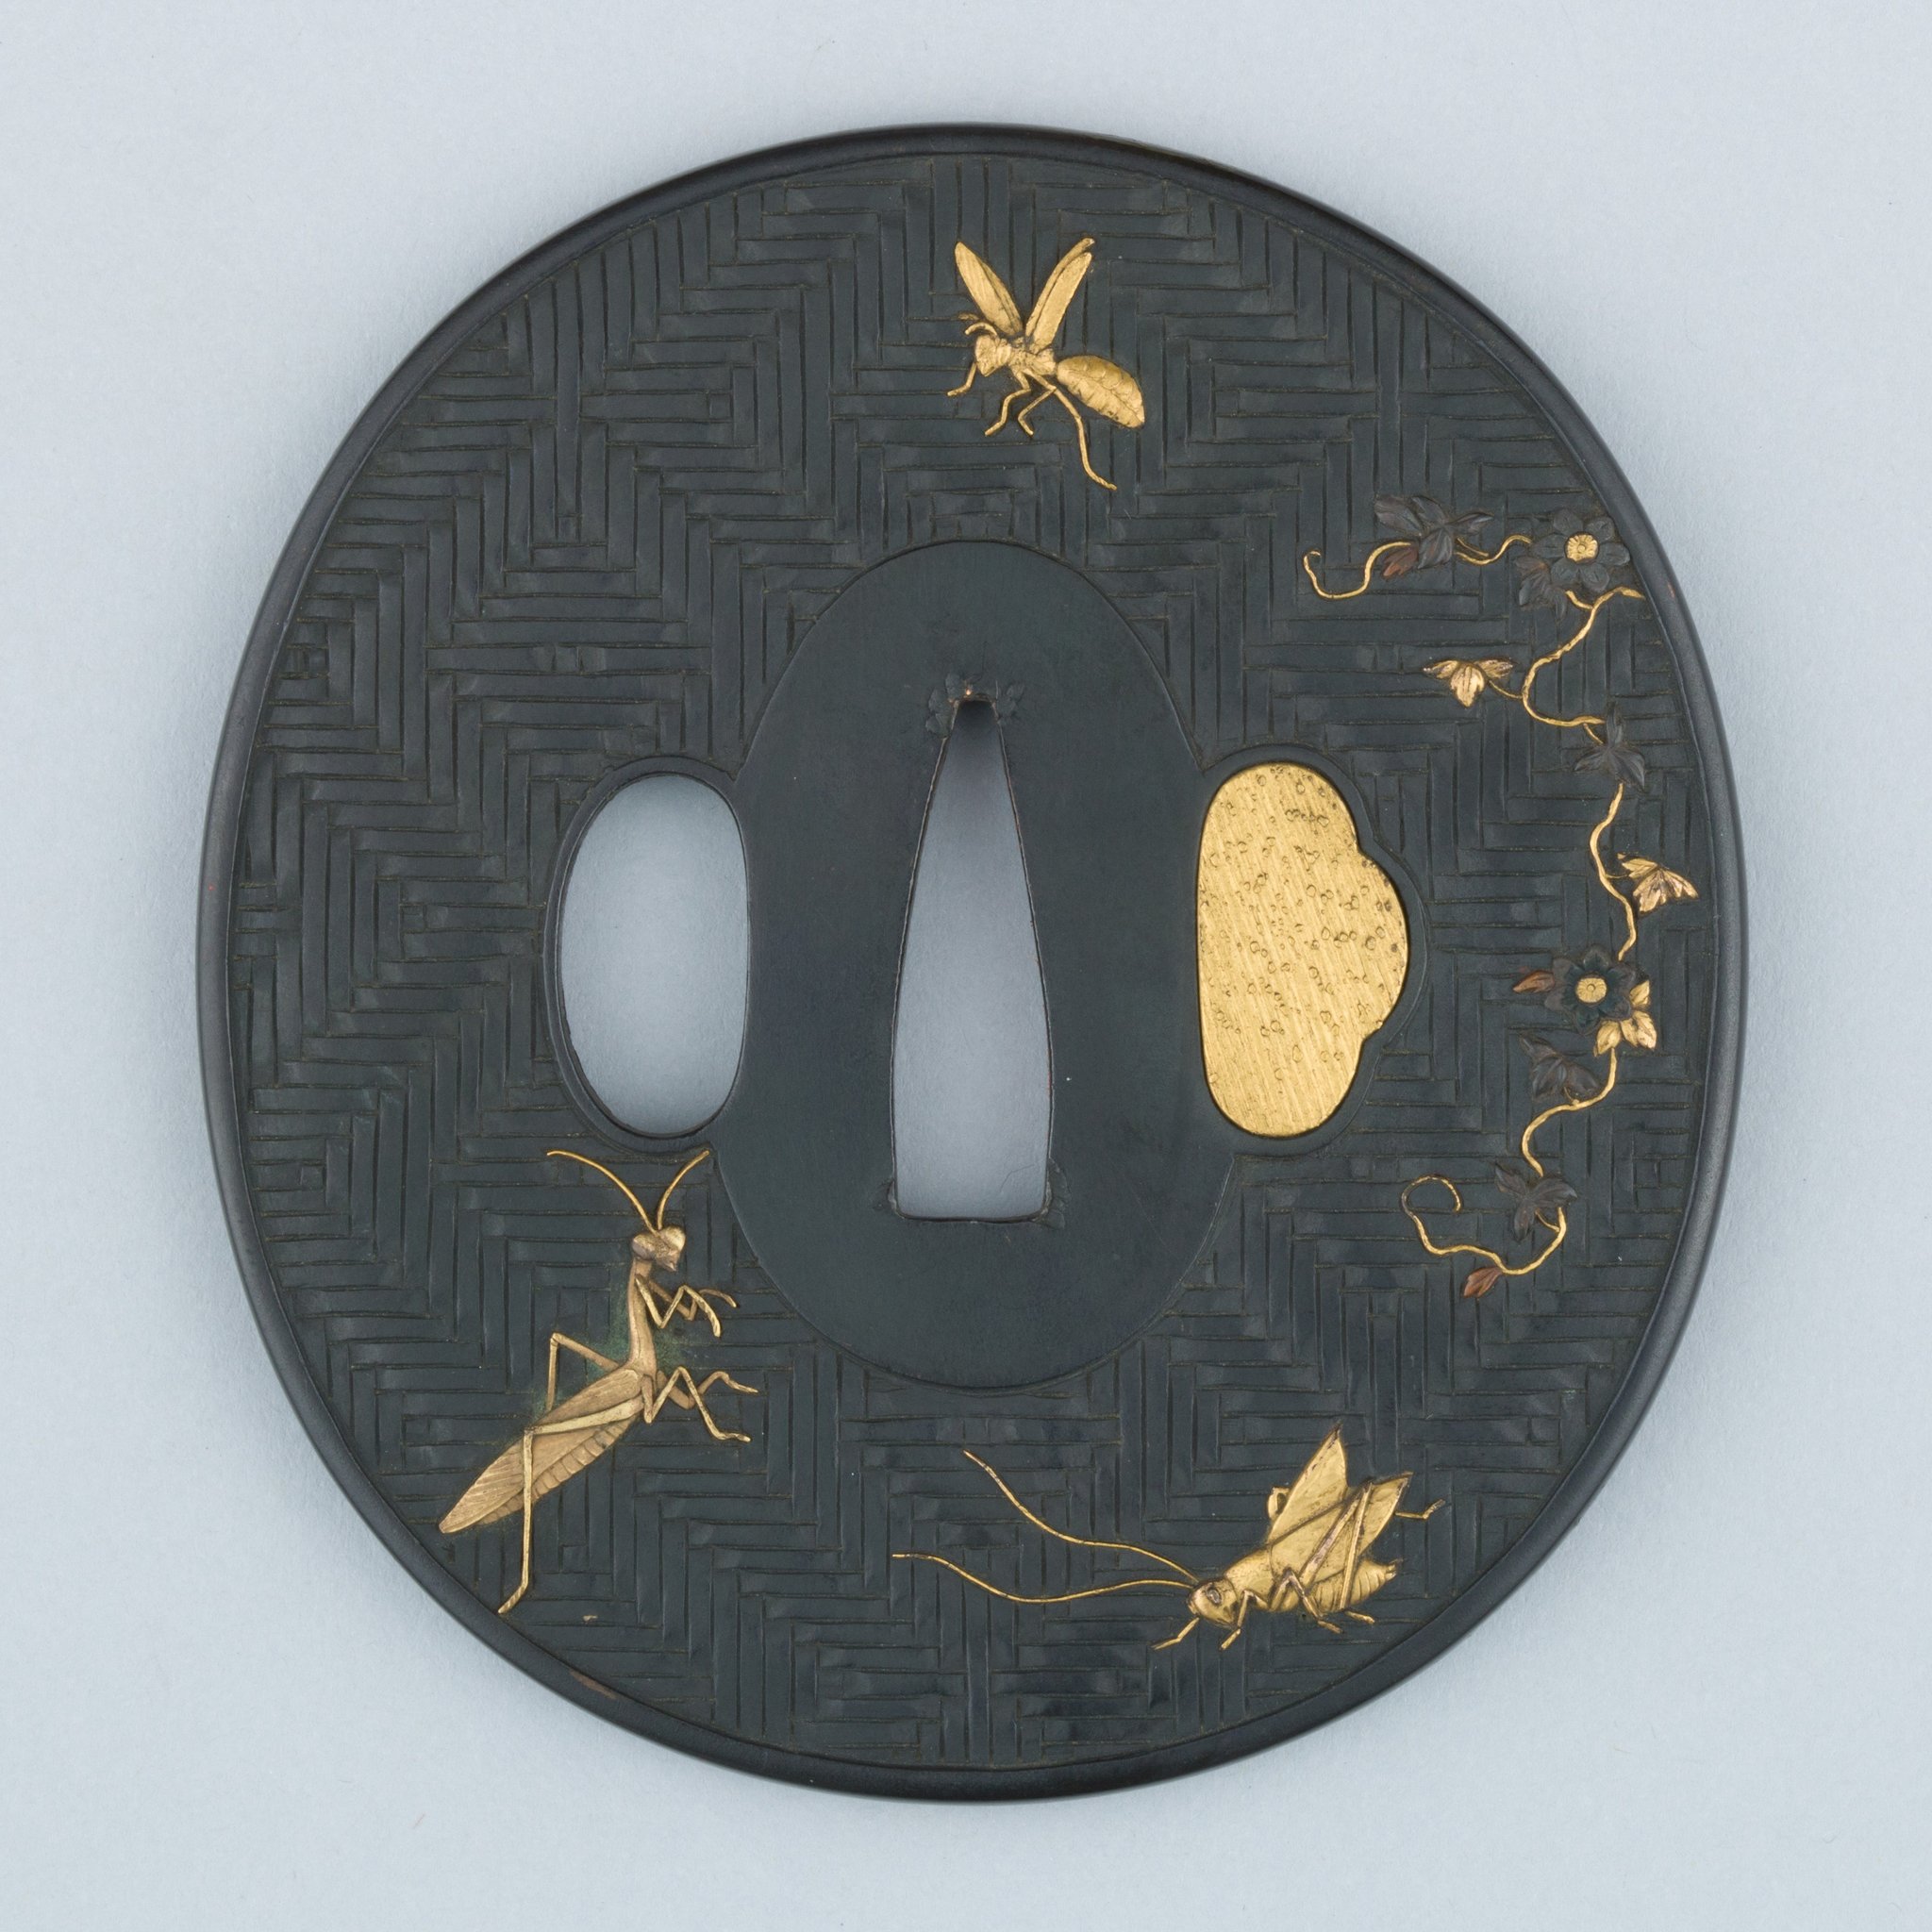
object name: sword guard tsuba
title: Sword Guard (Tsuba)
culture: japanese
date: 1615-1868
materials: copper, gold alloy, gold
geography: japan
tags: insects